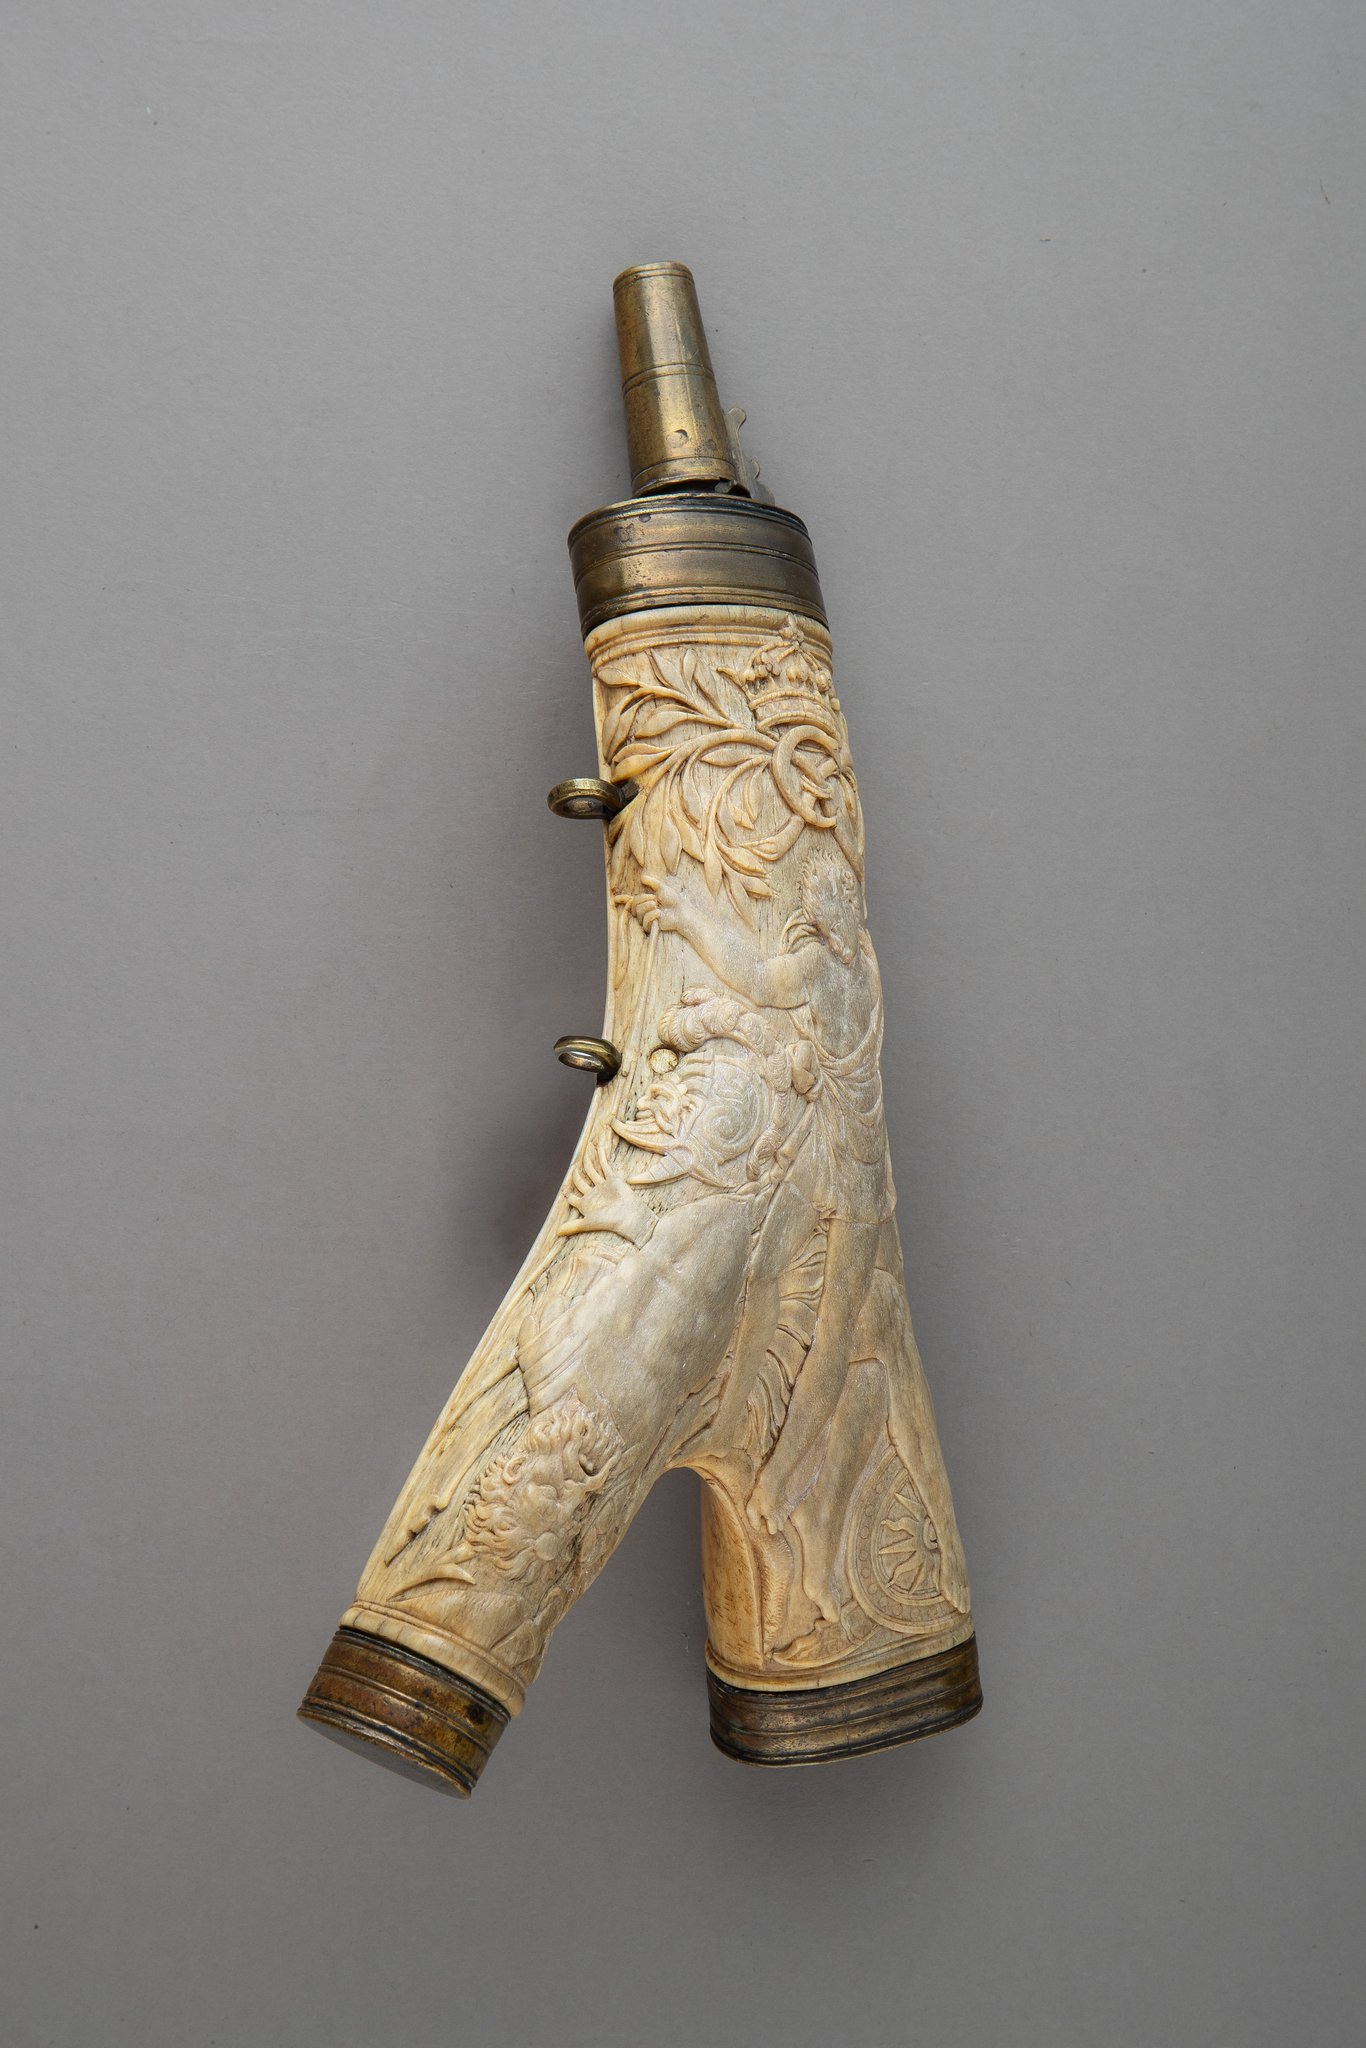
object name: powder flask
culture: french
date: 1570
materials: antler, metal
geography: france